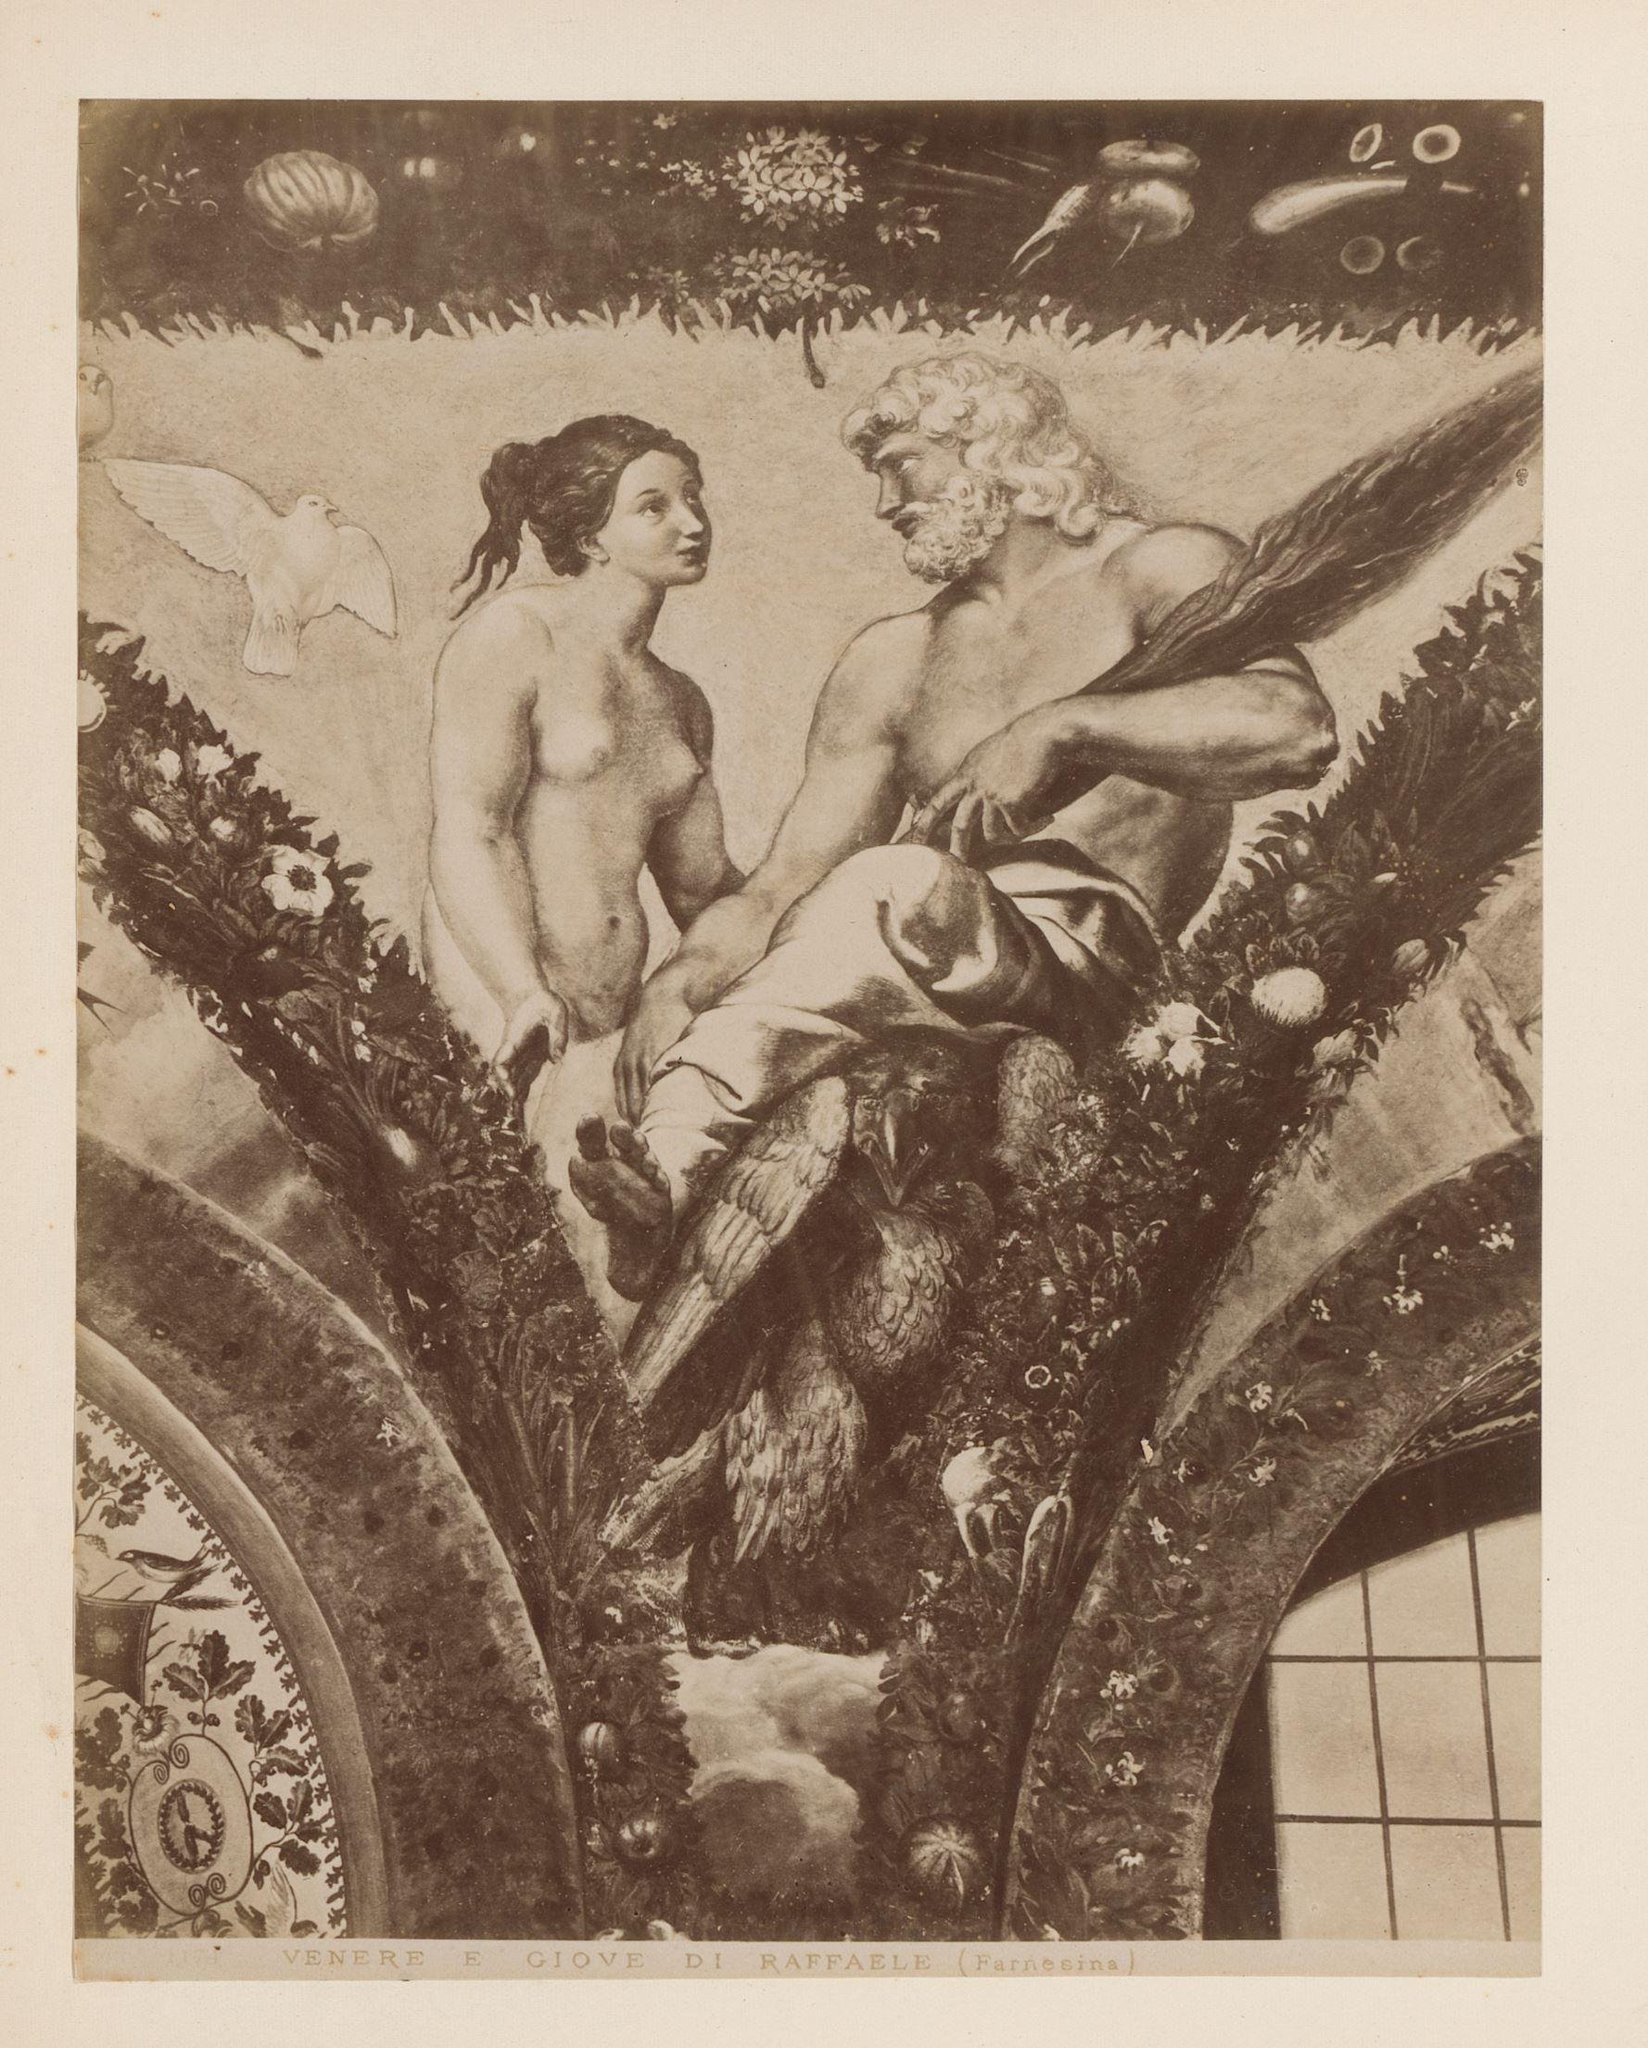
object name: reproduction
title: Fotoreproductie van fresco Venus en Jupiter door Rafaël in het Farnesina te Rome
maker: domenico anderson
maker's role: fotograaf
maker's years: 1854-1939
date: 1870-1890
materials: paper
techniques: albumen print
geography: villa farnesina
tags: picture, painting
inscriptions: inscription: ‘1174 Venere e Giove di Raffaele (Farnesina)’